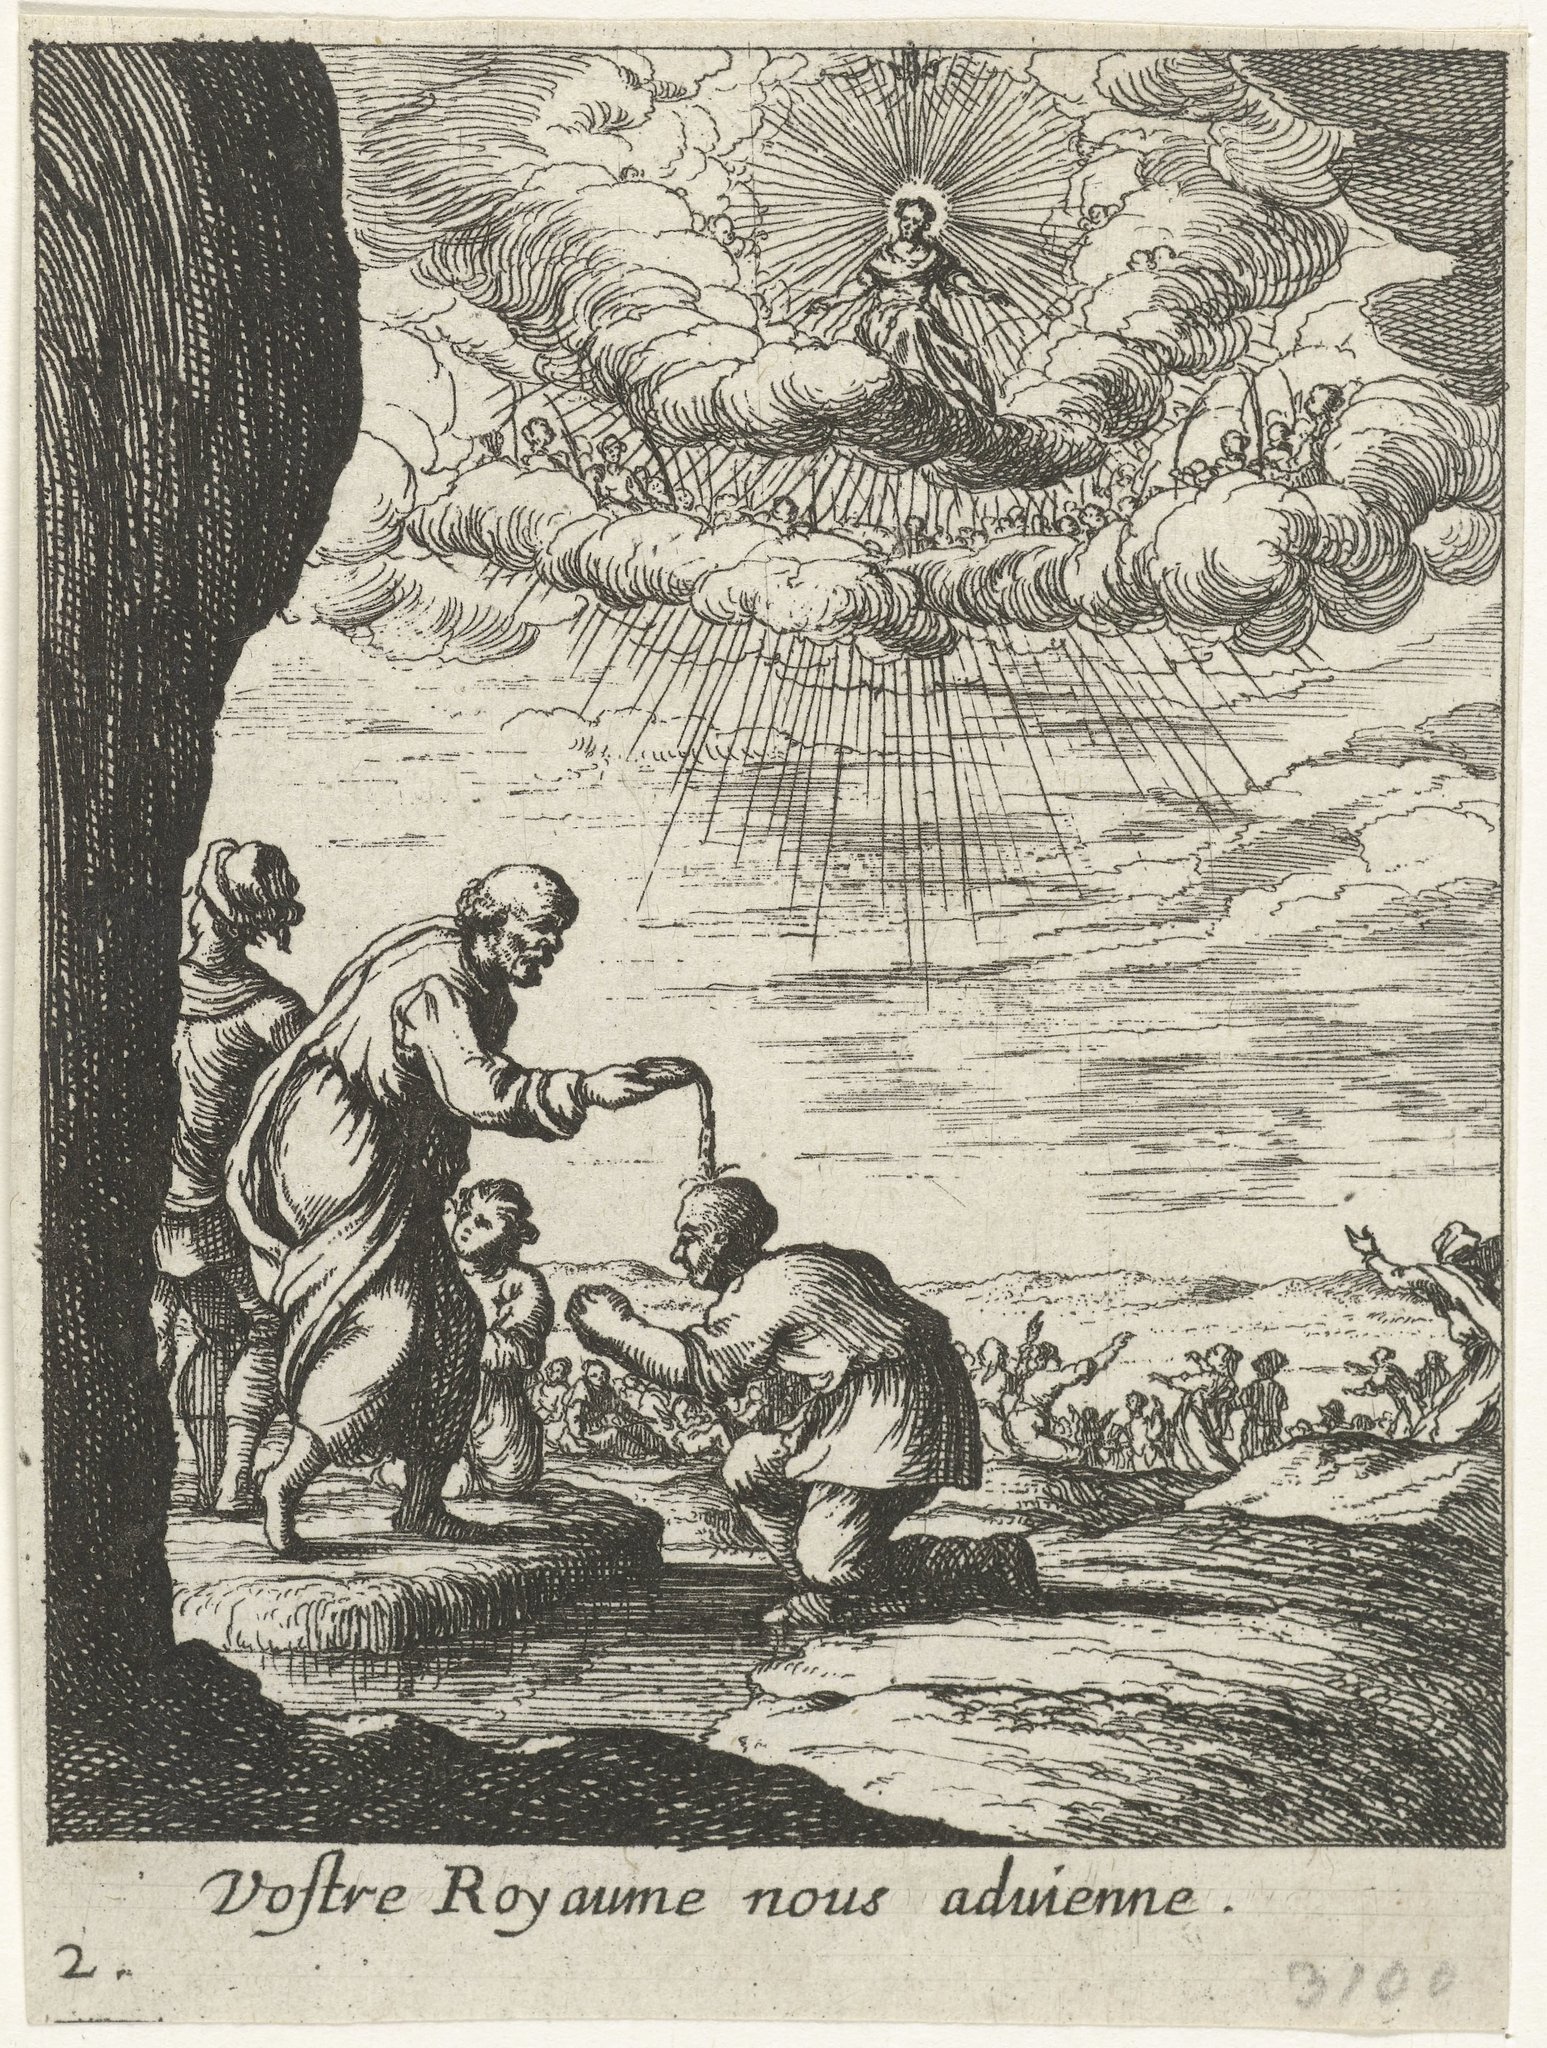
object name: print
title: Onze Vader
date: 1648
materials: paper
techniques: etching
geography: france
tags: 'thy kingdom come' ~ the lord's prayer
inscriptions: collector's mark: Lugt 2228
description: In een bergachtig landschap doopt een staande man een geknielde man. Op de achtergrond kijken mensen naar de hemel waar Christus verschijnt. Het Franse onderschrift is een deel uit het gebed het Onze Vader.